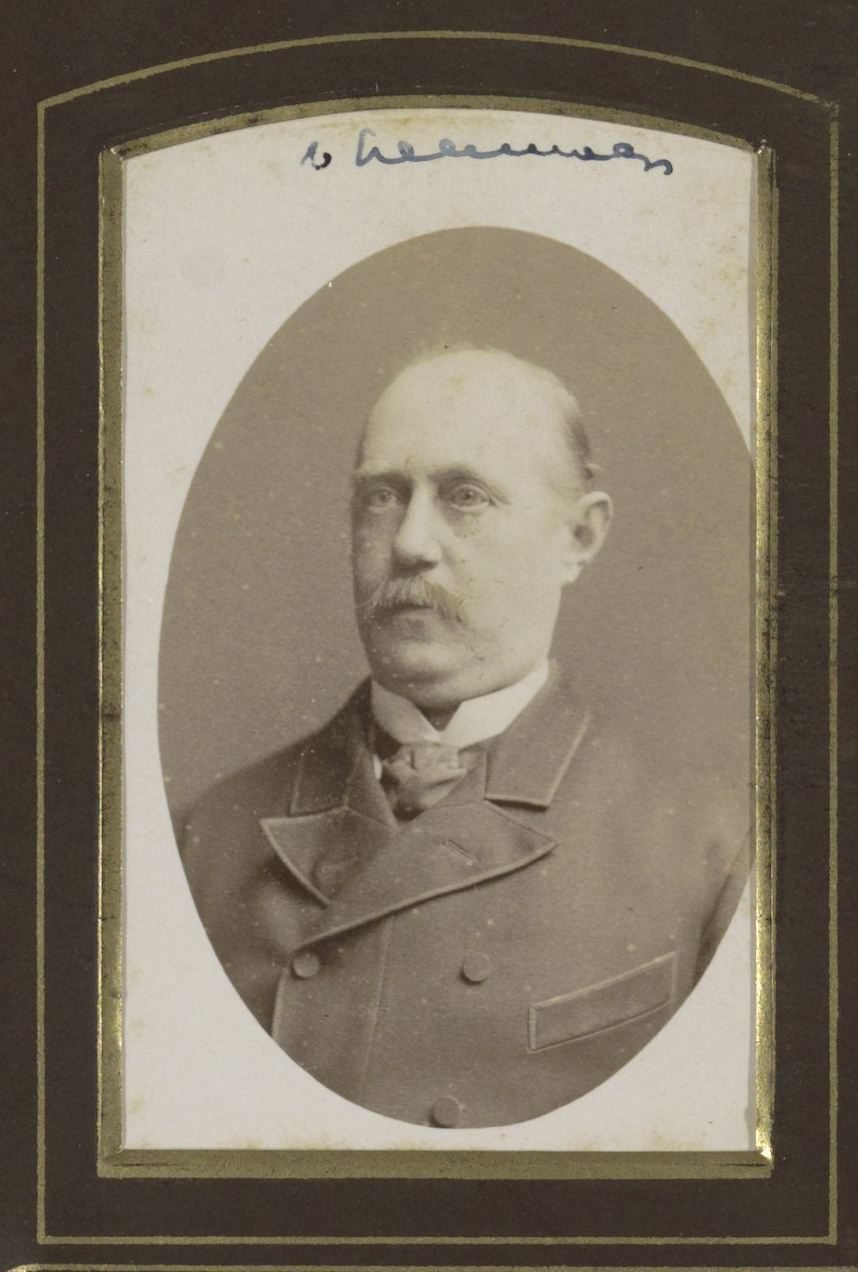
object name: album leaf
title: Portret van de heer Van Leeuwen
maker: heinrich wilhelm wollrabe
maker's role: fotograaf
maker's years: 1843-1928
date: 1885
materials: cardboard, paper, photographic support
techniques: albumen print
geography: the hague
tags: adult man, historical persons, the hague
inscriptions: address: ‘Noordeinde 96 's Gravenhage’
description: Onderdeel van Fotoalbum van de families Matthes, Doorman en Van Thiel.